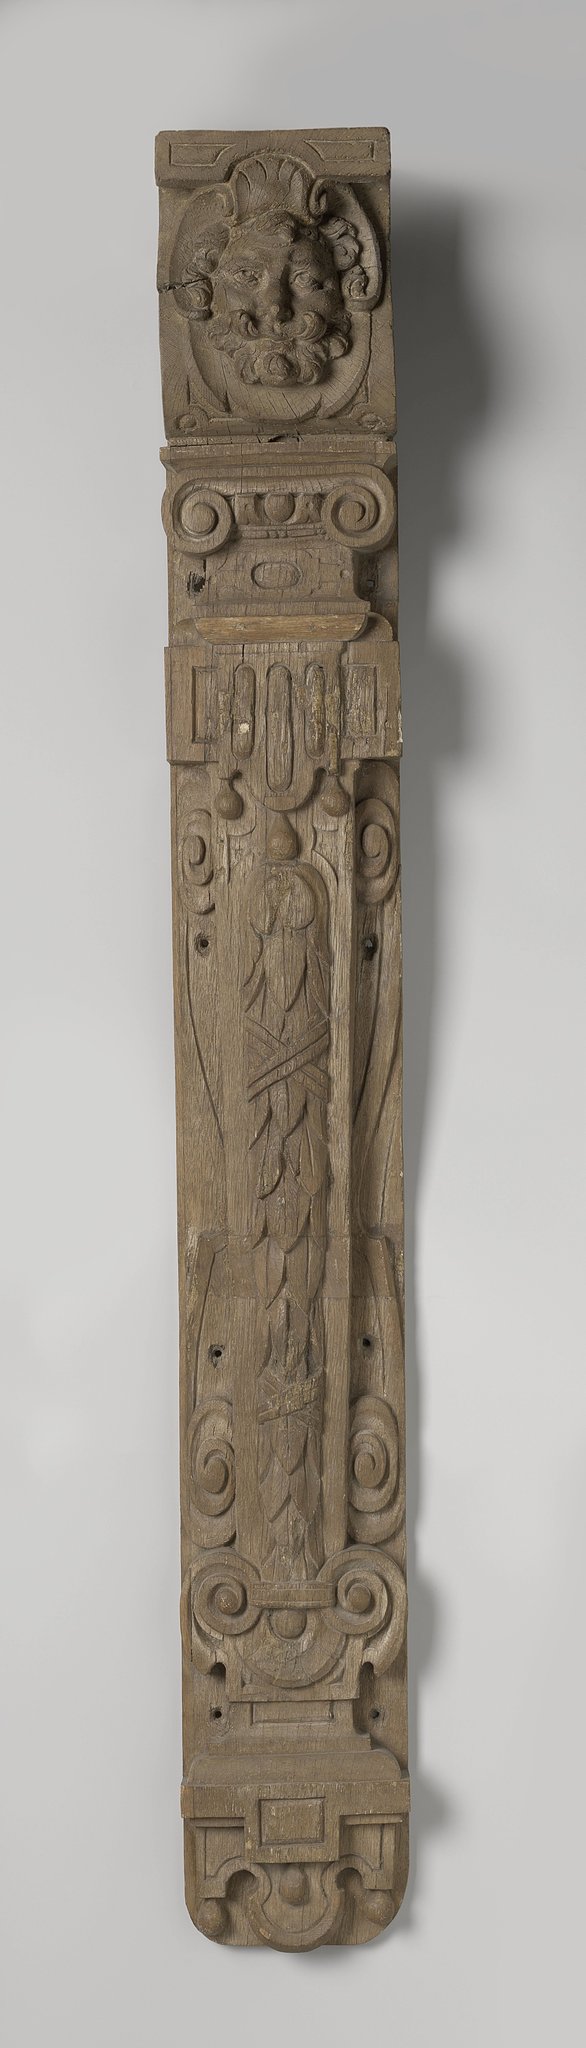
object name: architectural element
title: Gebeeldhouwde stijl van eikenhout, afkomstig uit het z.g. Huis van Alva, Warmoestraat te Amsterdam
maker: Anonymous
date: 1500-1699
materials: wood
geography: northern netherlands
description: Gebeeldhouwde eikenhouten stijl zonder afwerking, afkomstig uit het z.g. Huis van Alva, Warmoestraat te Amsterdam. In totaal gaat het om twee consoles, drie brede en drie smalle stijlen (BK-KOG-755-A, B, D t/m H). Zie tevens BK-KOG-754-1 t/m 7, dit zijn 6 beschilderde stijlen die uit hetzelfde huis afkomstig zijn.